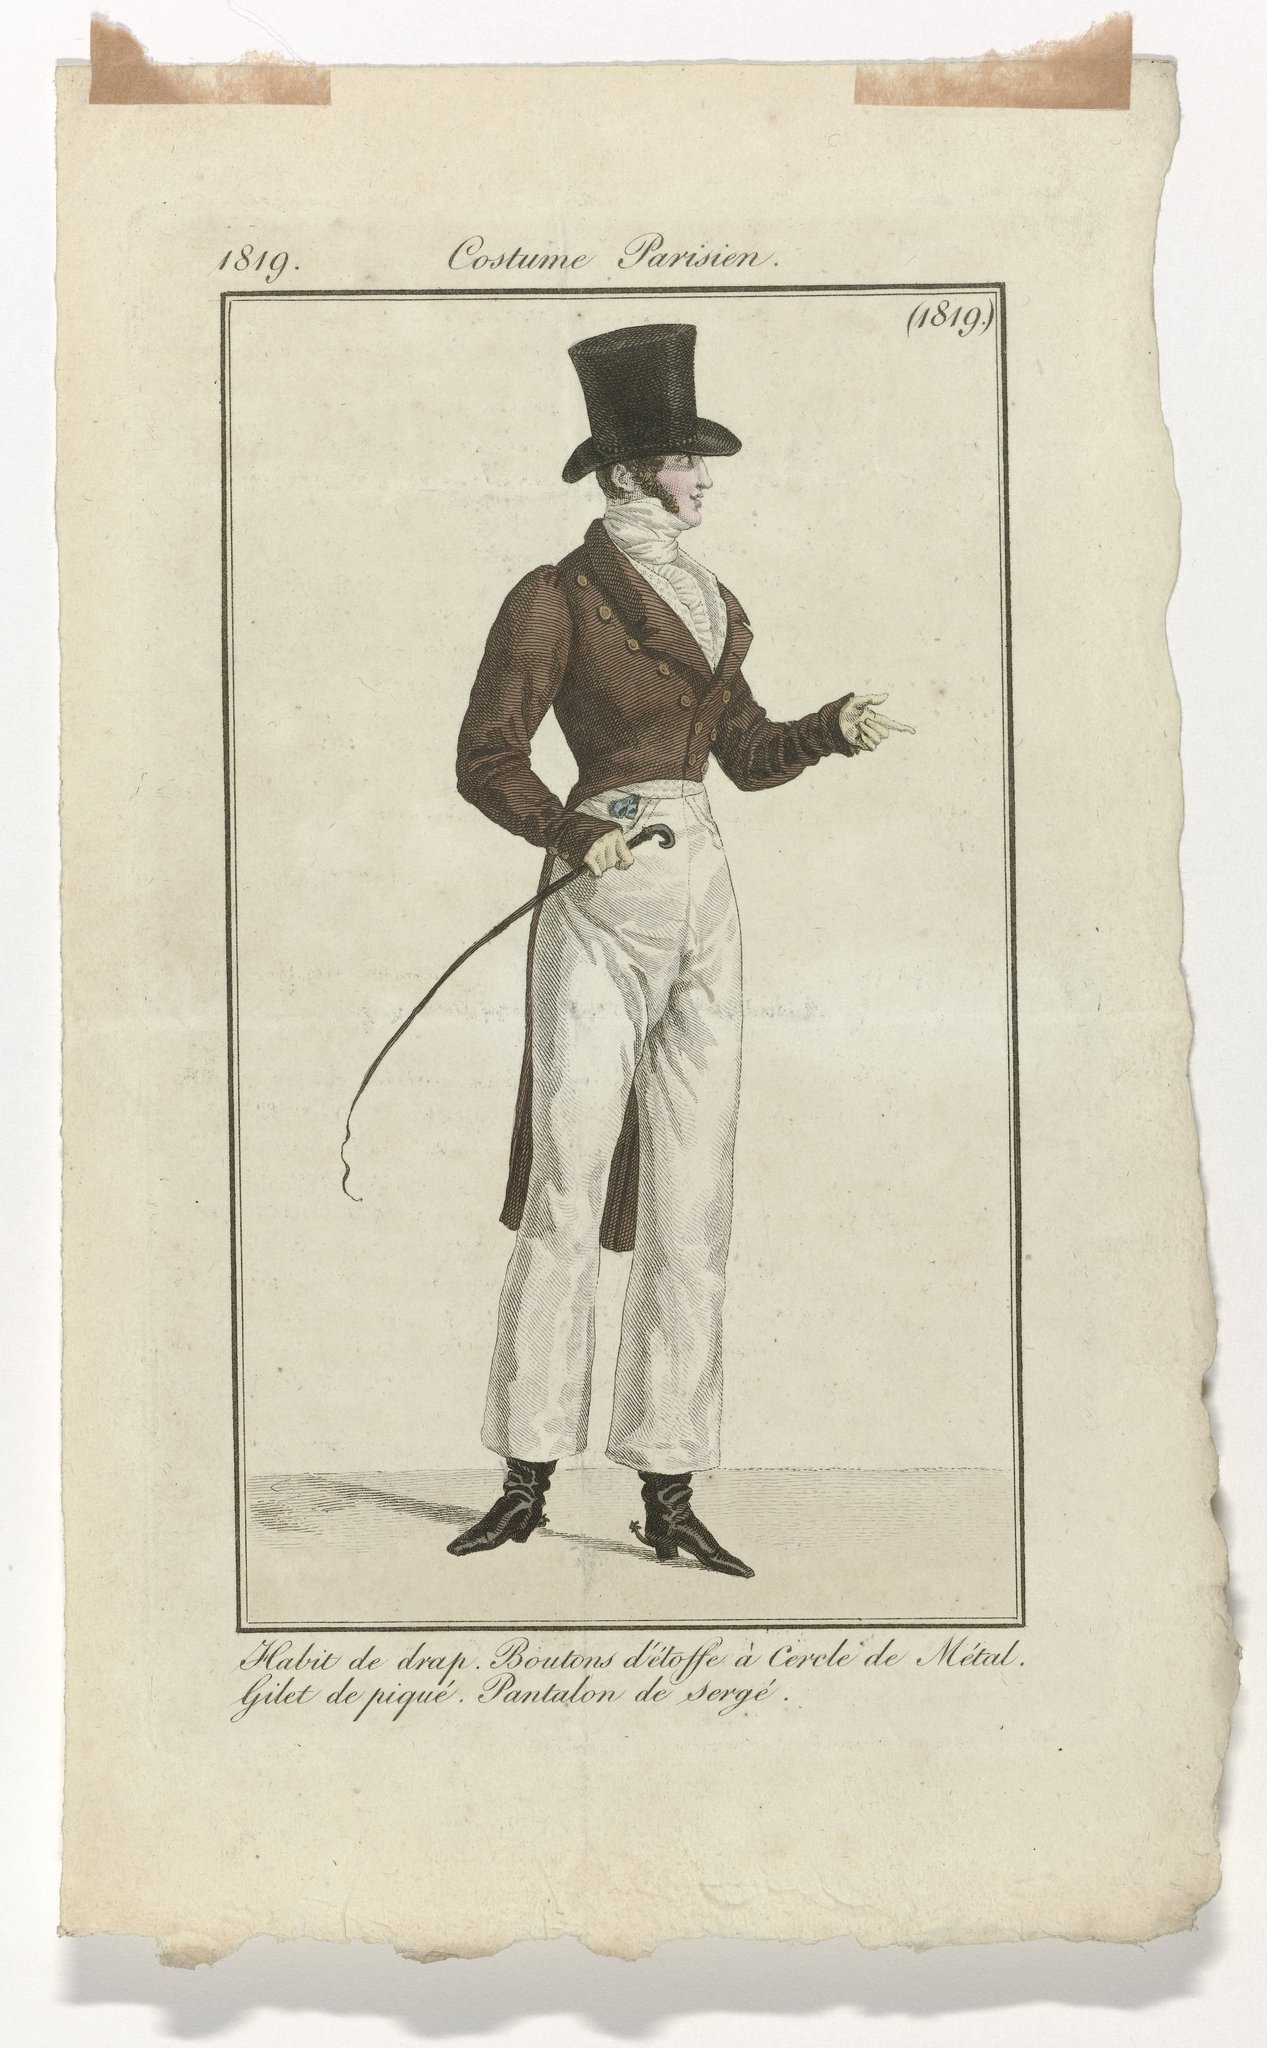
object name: fashion print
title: Journal des Dames et des Modes, Costume Parisien, 31 mai 1819, (1819): Habit de drap (...)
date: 1819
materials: paper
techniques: engraving, hand coloring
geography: paris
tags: clothing for the upper part of the body (vest) (+ men's clothes), neck-gear ~ clothing (+ men's clothes), trousers, breeches, etc. (pantalon) (+ men's clothes), button (+ men's clothes), button (+ other materials used for clothes), coat (+ men's clothes), fashion plates, boots (+ men's clothes), gloves, mittens, etc. (+ men's clothes), whip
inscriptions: caption: ‘Habit de drap. Boutons d'étoffe à cercle de Métal. Gilet de piqué. Pantalon de sergé.’, title: ‘Costume Parisien.’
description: Staande man gekleed in een 'habit' van laken, knopen van stof met cirkel van metaal. Hij draagt een vest van 'piqué' op een lange broek van 'sergé'. Hemd met geplooide jabot. Halsdoek. Accessoires: hoge hoed, handschoenen, zweep, laarzen met hakken en sporen. Prent uit van het modetijdschrift Journal des Dames et des Modes, uitgegeven door Pierre de la Mésangère, Parijs, 1797-1839.